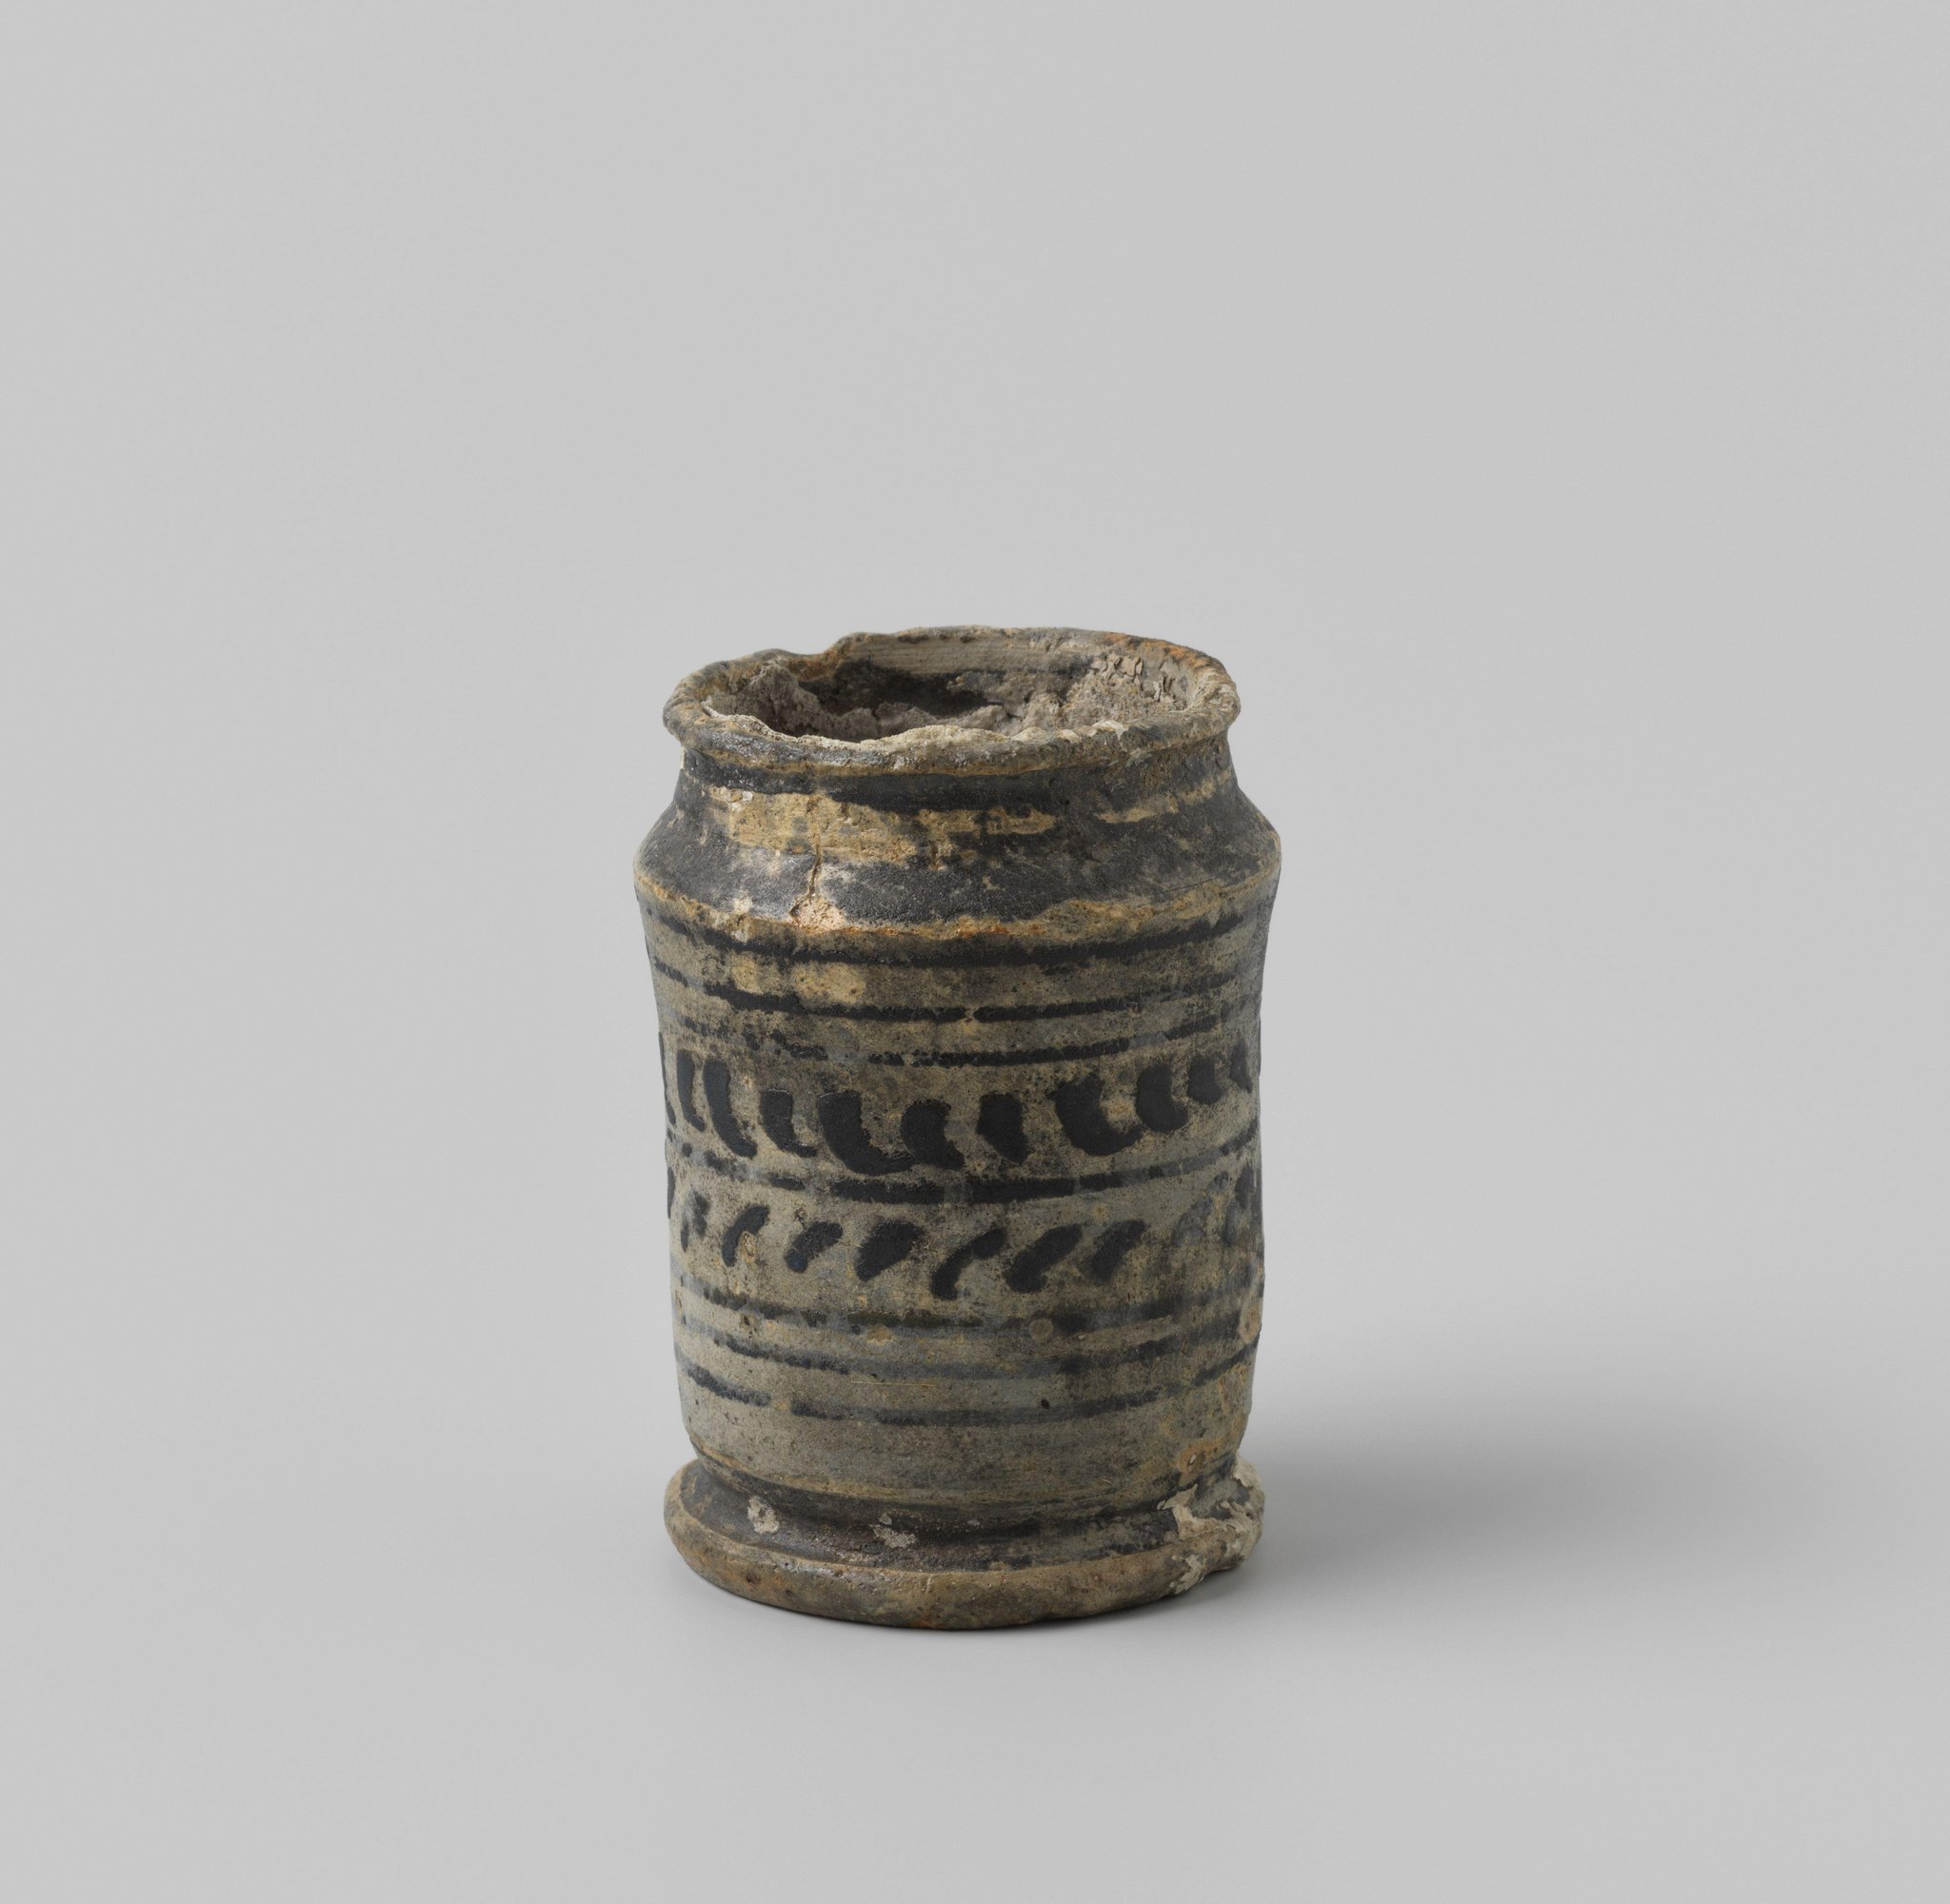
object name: ointment vessel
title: Zalfpot uit V.O.C.-schip de 'Witte Leeuw'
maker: Anonymous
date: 1613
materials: earthenware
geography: europe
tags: verenigde oostindische compagnie, sint-helena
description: Zalfpot uit V.O.C.-schip de 'Witte Leeuw', compleet. De pot is cylindervormig, heeft een voetprofiel en heeft een ingesnoerde basis en hals. De basis is ruw afgewerkt. De scherf is grijs. Op de wand zitten 2 rijen met kommavormige reliëfs omsloten door 3 banden in reliëf.